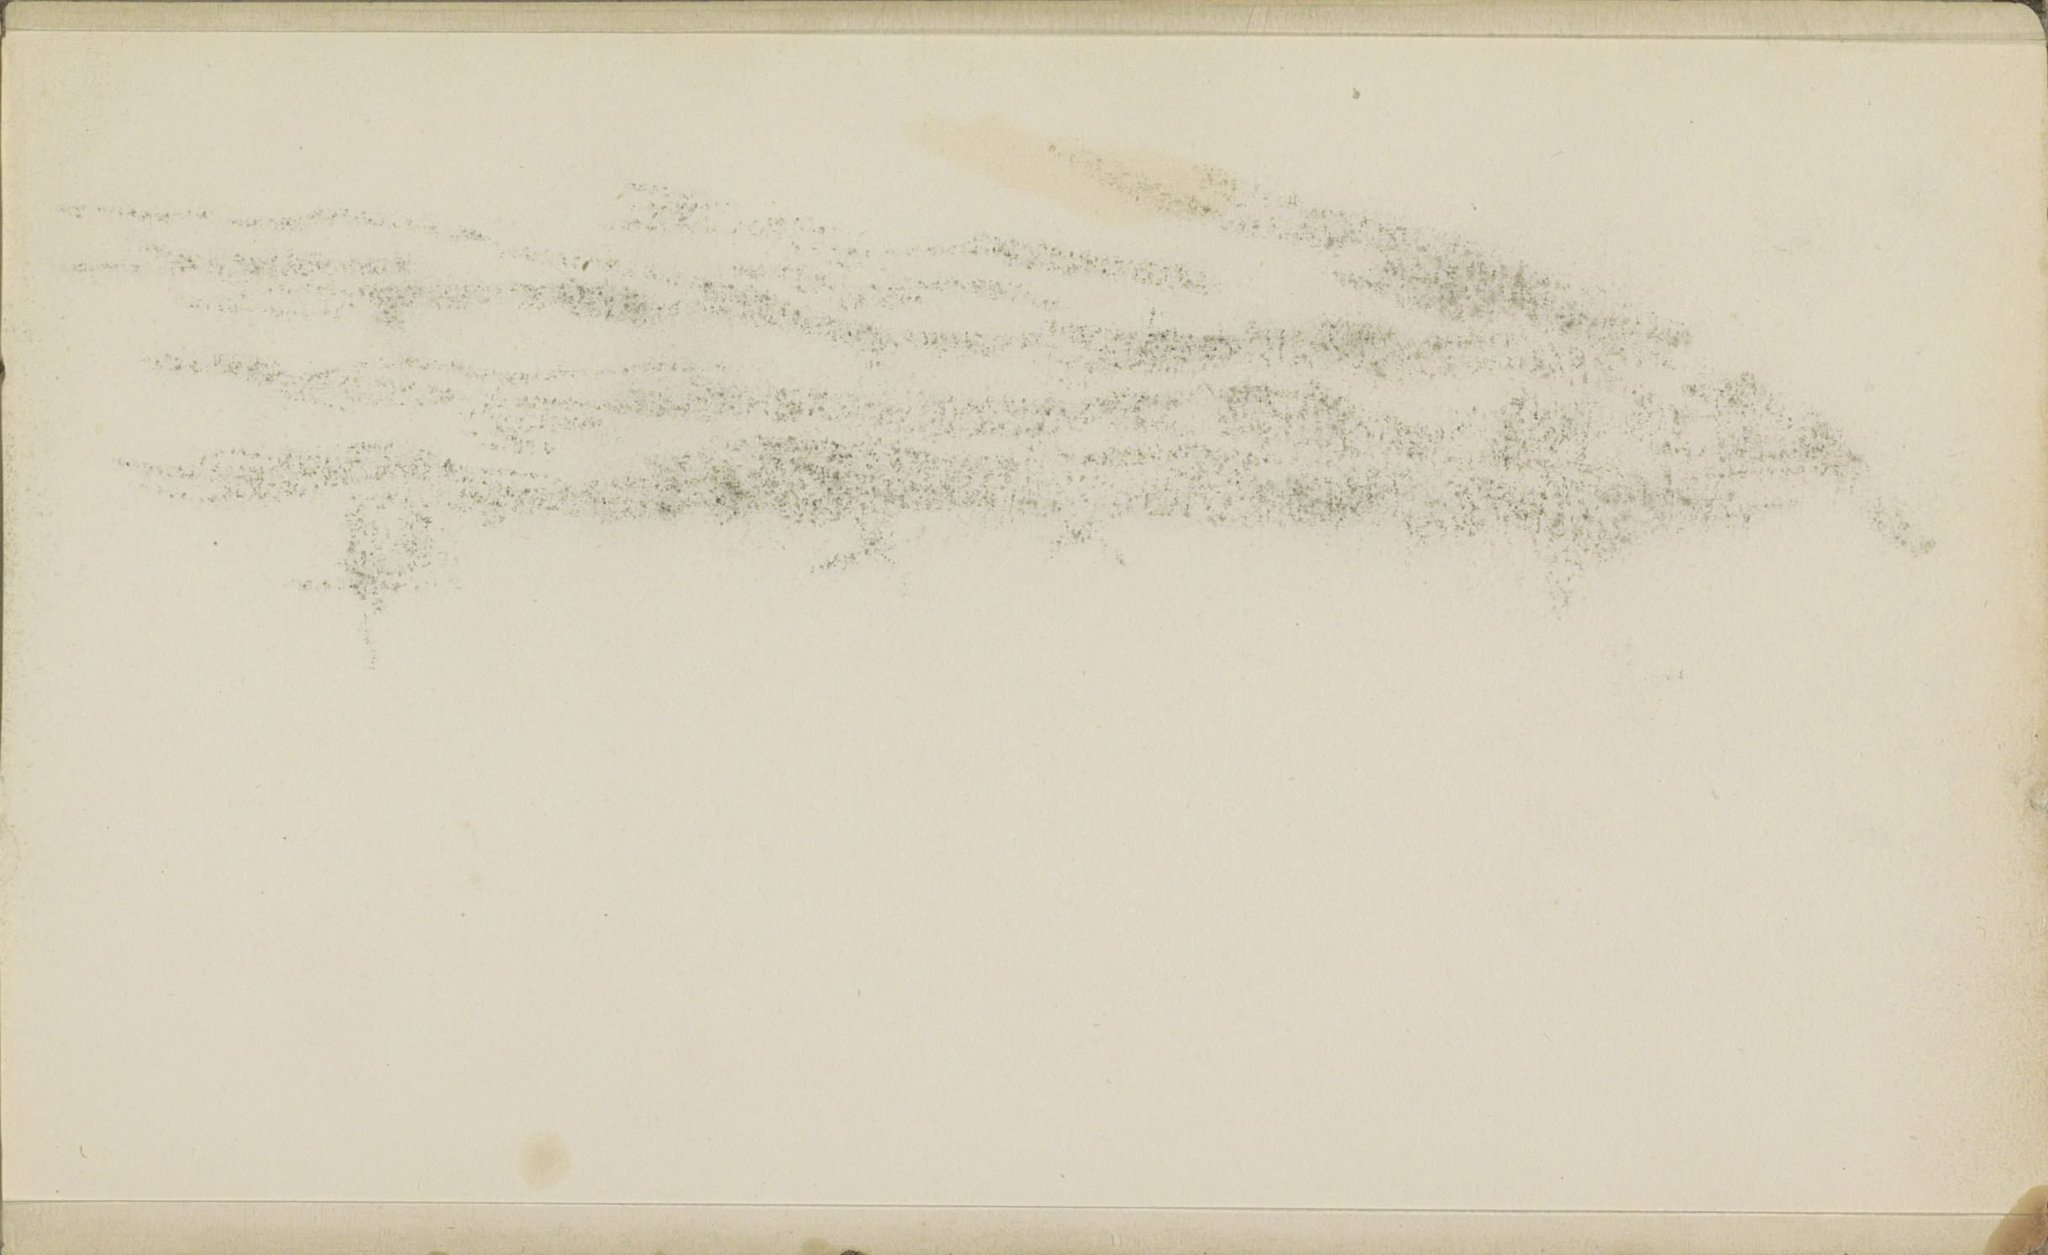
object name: sketchbook leaf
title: Abklatsch van de krijttekening op pagina 41 verso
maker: jozef israëls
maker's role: draughtsman, painter, print maker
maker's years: 1824-1911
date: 1834-1911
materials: paper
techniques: printmaking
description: Blad 42 recto uit een schetsboek met 42 bladen.